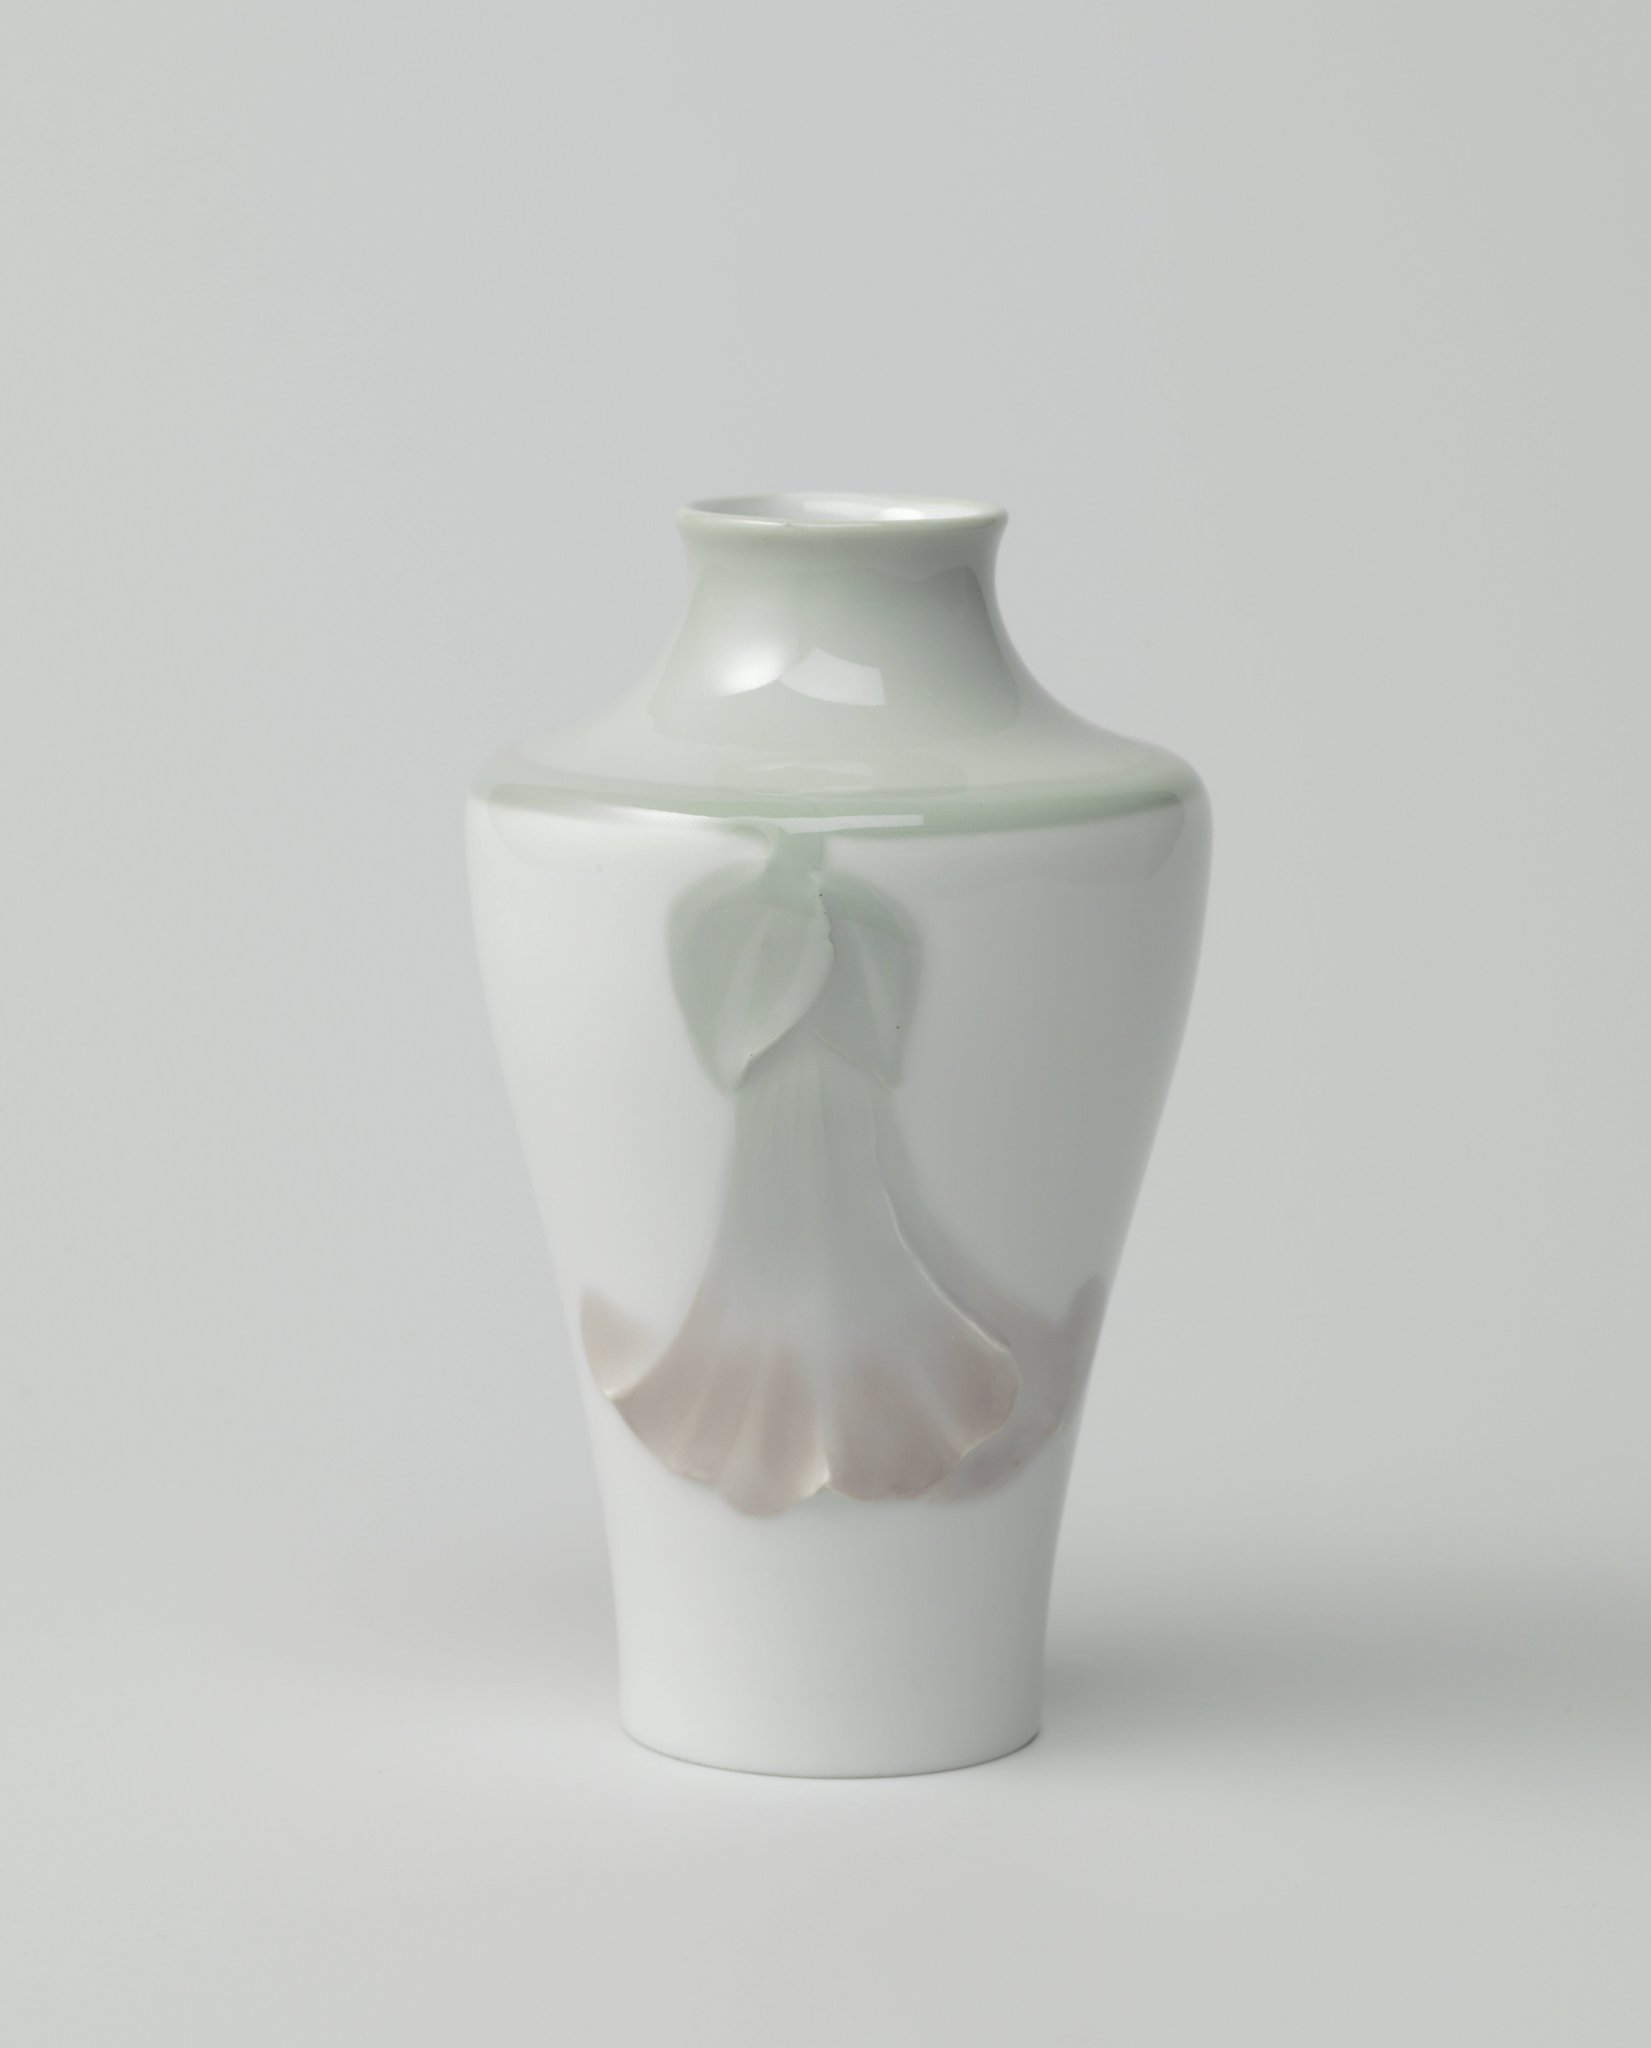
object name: vase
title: Vaas met van schouder afhangende bloemkelk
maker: karl lindström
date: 1900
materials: porcelain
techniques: painted, pâte sur pâte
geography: denmark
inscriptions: mark: ‘fabrieksmerk en letters KL (in groen) ; 40355 en EG (ingestempeld); een gedeeltelijk leesbaar merk met 6 en L.’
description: Vaas van porselein, versierd in pâte-sur-pâte in roze en groen met aan weerszijden een van de geheel groene schouder, afhangende bloemkelk.